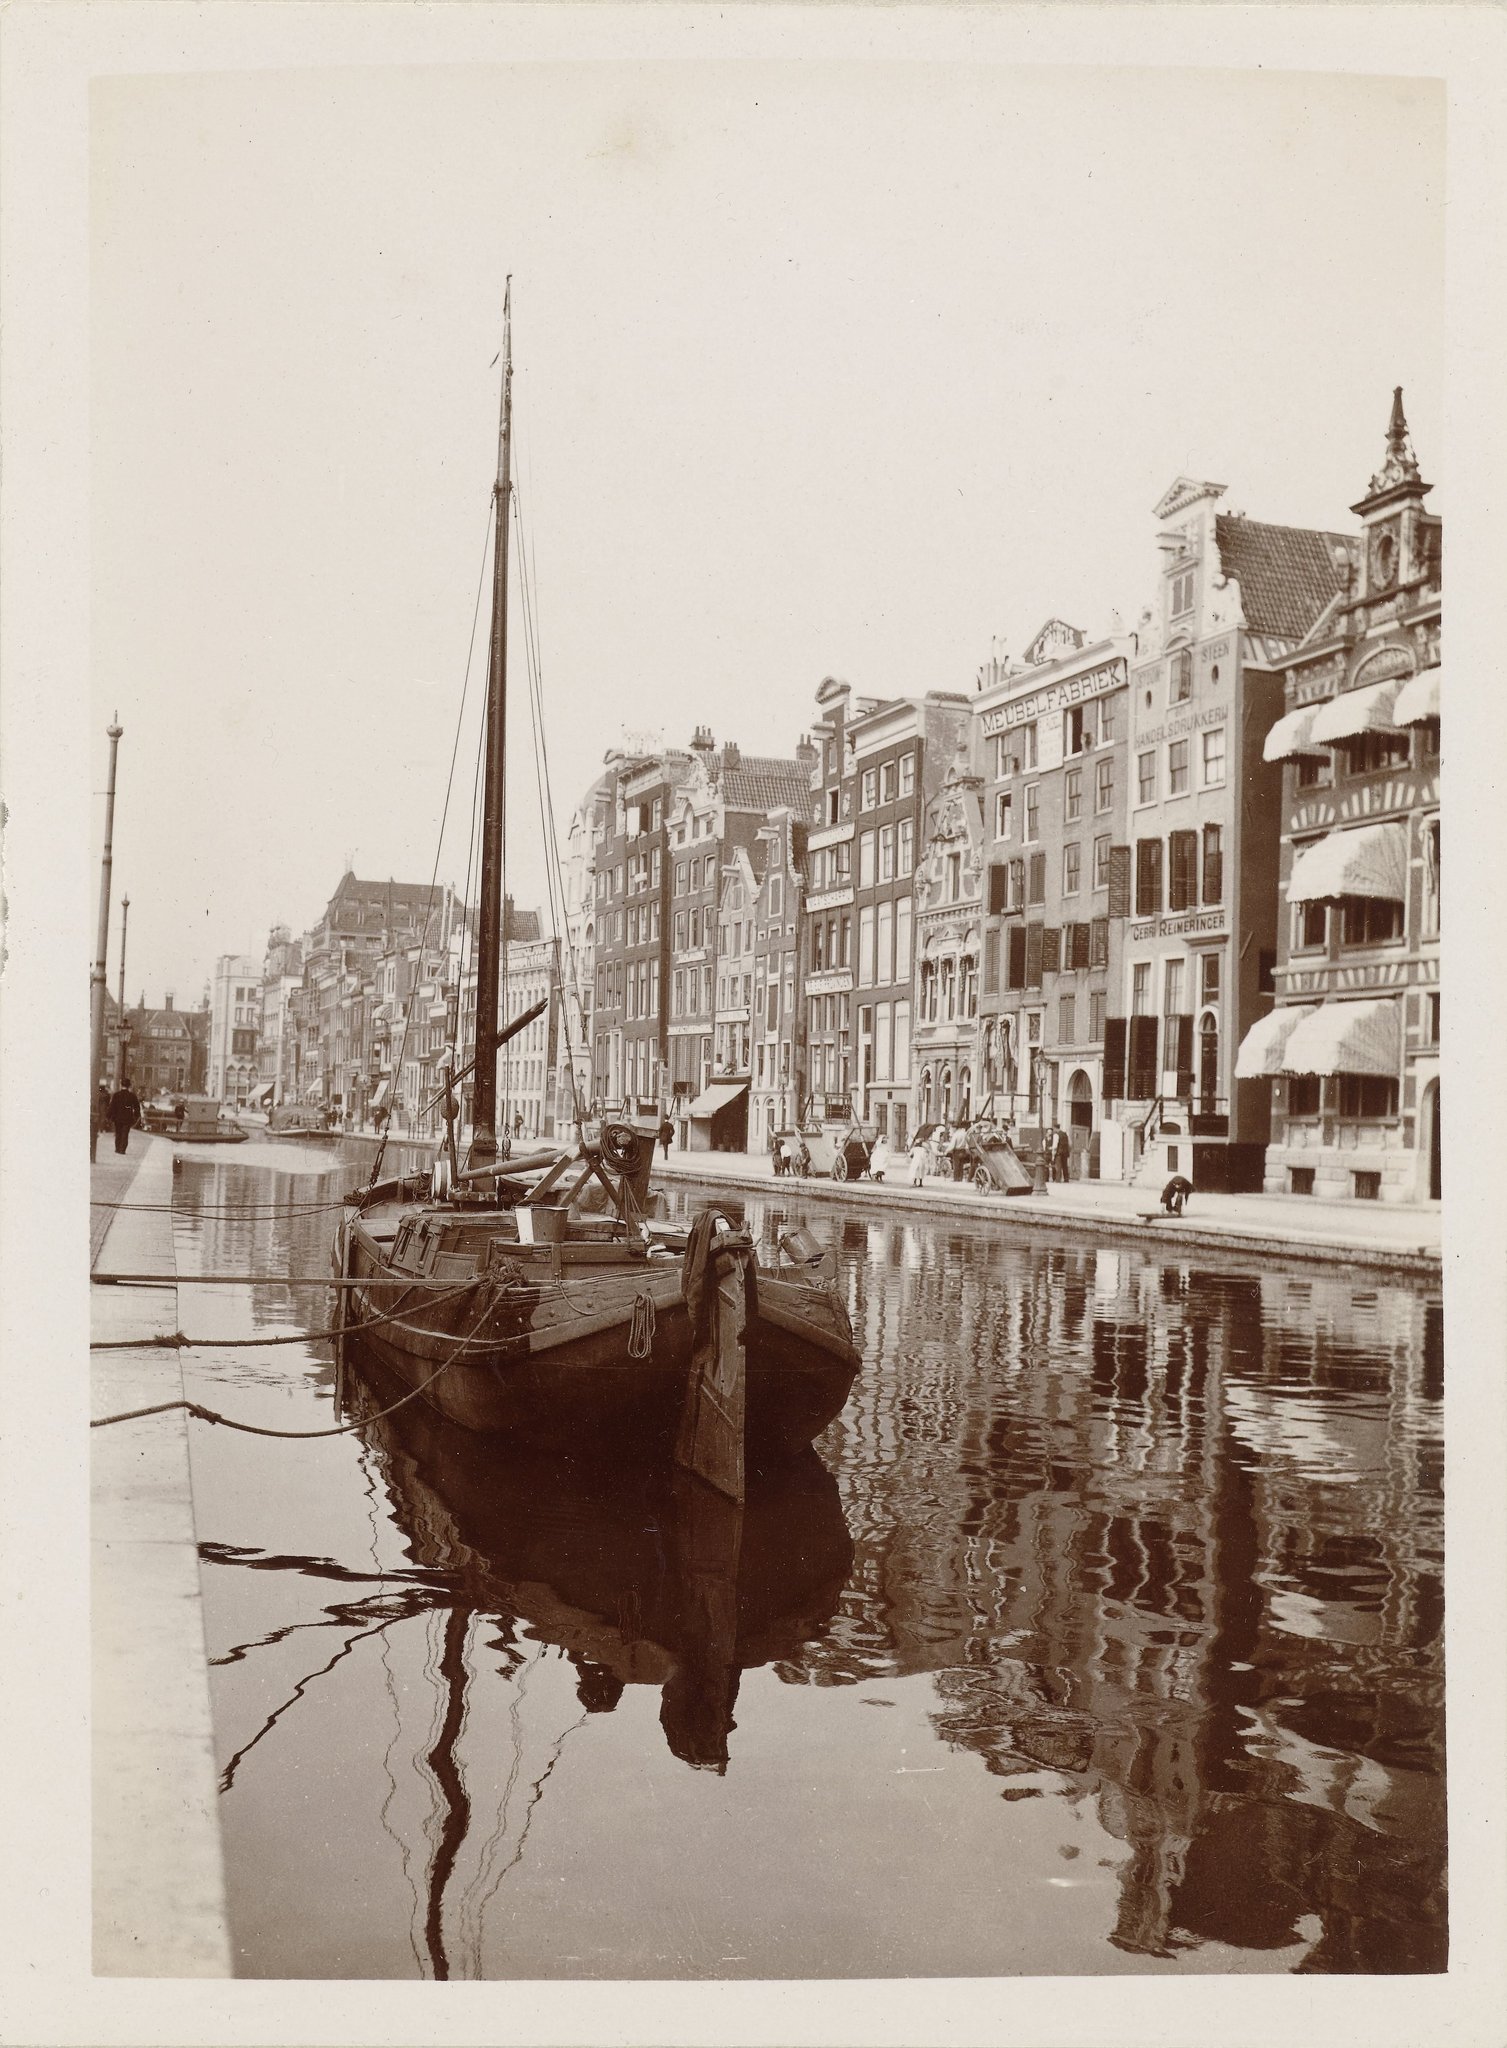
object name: photograph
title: Rokin in Amsterdam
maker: james higson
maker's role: politician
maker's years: 1862-1933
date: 1904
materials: paper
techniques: gelatin silver print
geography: amsterdam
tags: ships (in general)